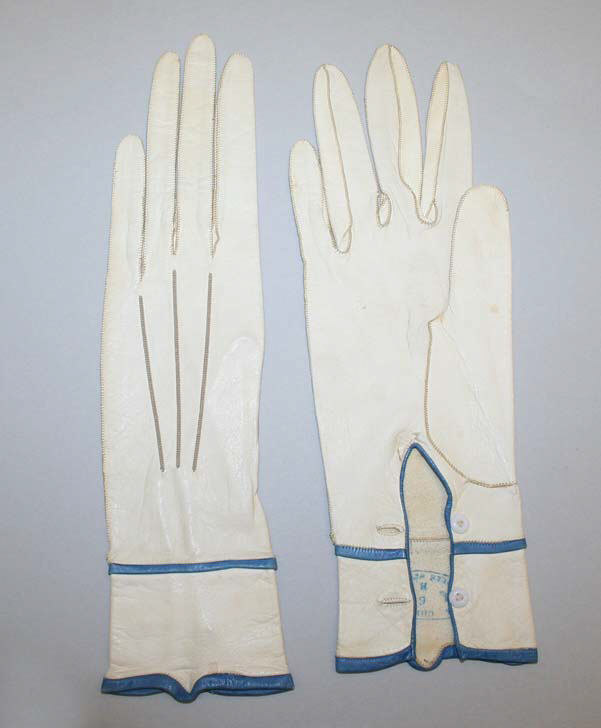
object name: glove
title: Gloves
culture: french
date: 1867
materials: leather